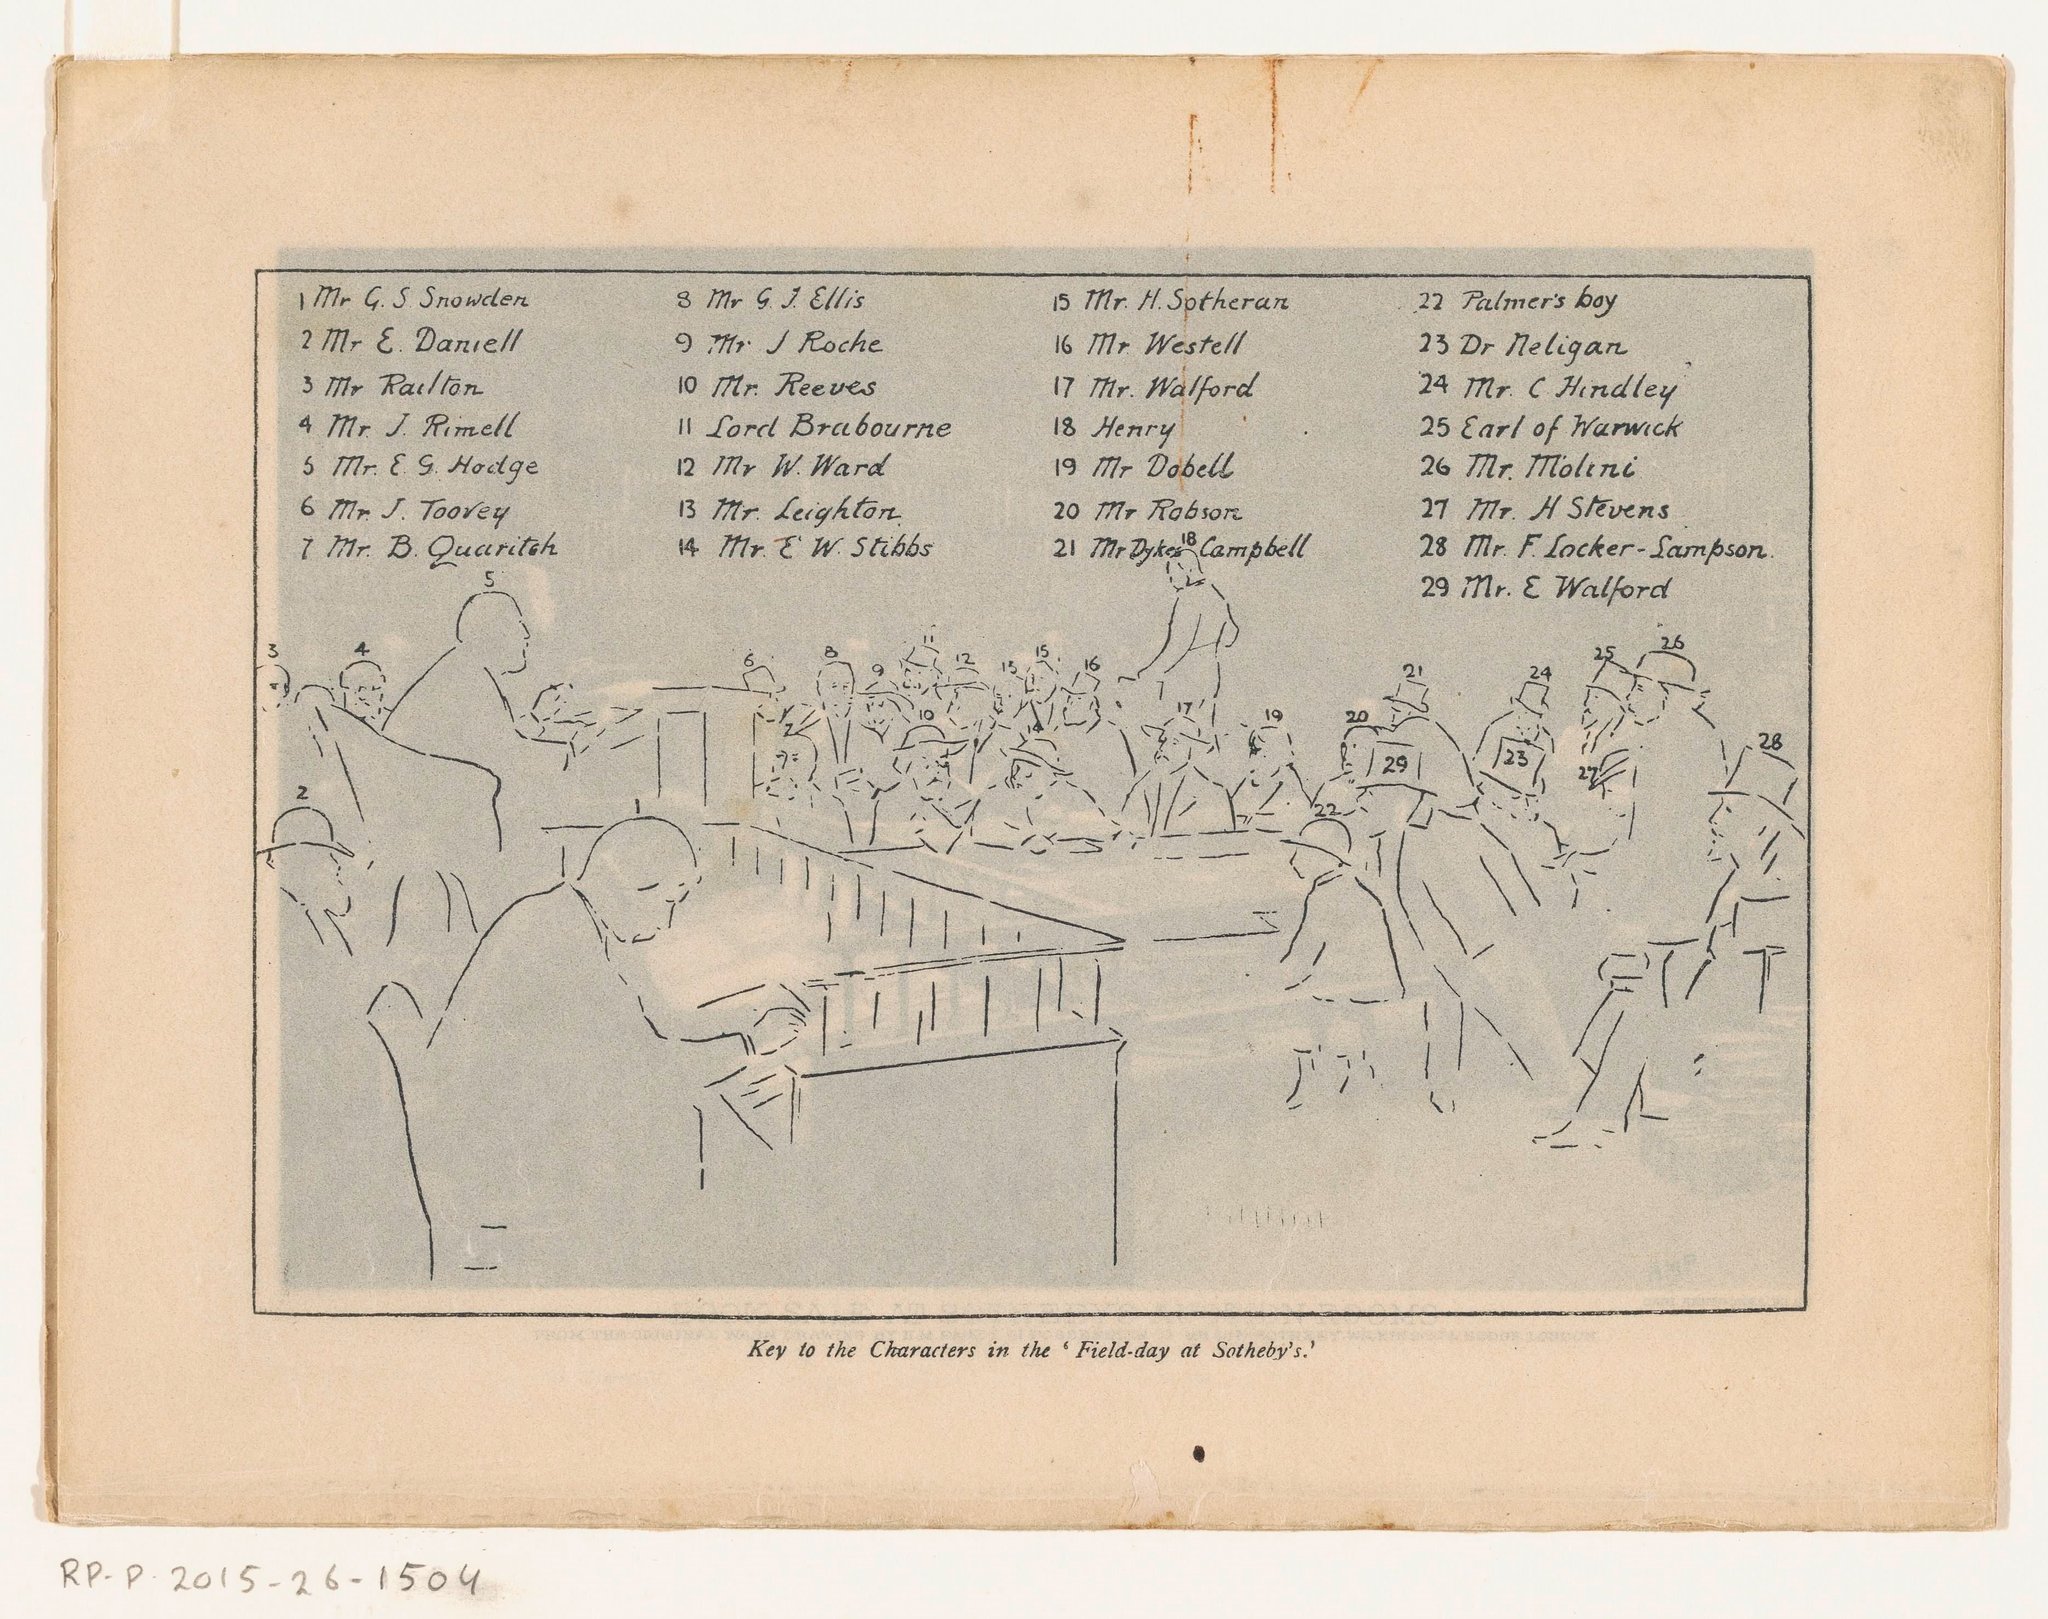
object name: book illustration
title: Book sale at Sotheby's auction rooms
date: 1904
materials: paper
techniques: photoaquatint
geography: london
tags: bookshelves, book, art sale, auction, book-shop, bookseller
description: Interieur van de veilingzaal met op een verhoging de veilingmeester, E.G. Hodge. Naast hem zit zijn klerk, G. Snowdon, te schrijven. De aanwezigen luisteren geïnteresseerd naar de veilingmeester of bekijken enkele boeken.